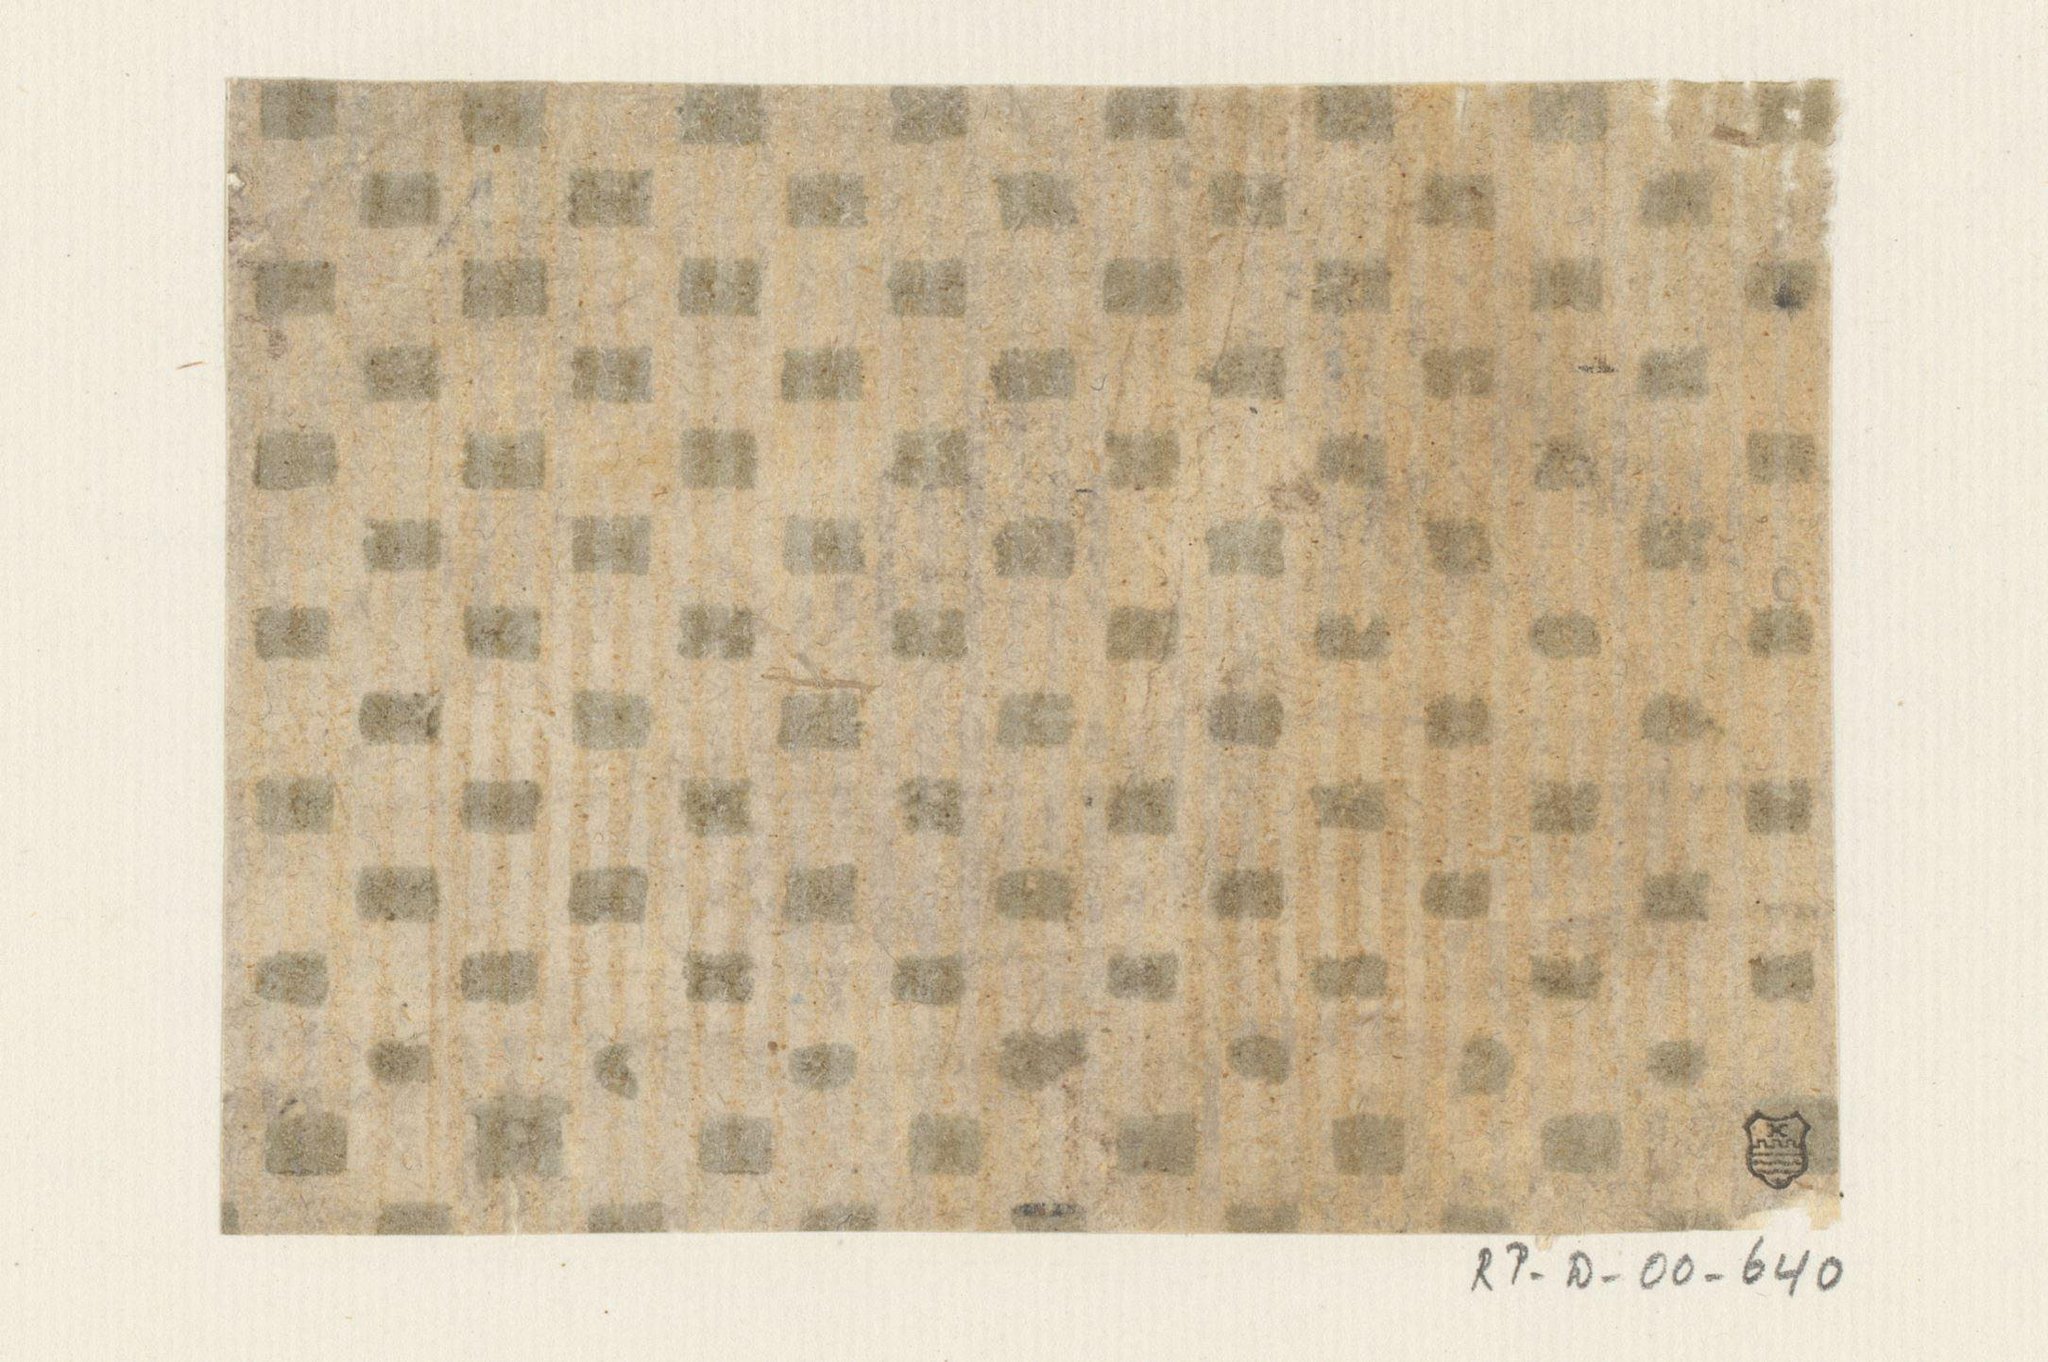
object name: printed paper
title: Blad met strooipatroon van rechthoeken op een lijnenfond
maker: Anonymous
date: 1750-1900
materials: paper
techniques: printing block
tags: ornament ~ straight lines (right angles only)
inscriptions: collector's mark: Lugt 2760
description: Blad met strooipatroon van rechthoeken (bijna schaakbordpatroon) op een verticaal lijnenfond.